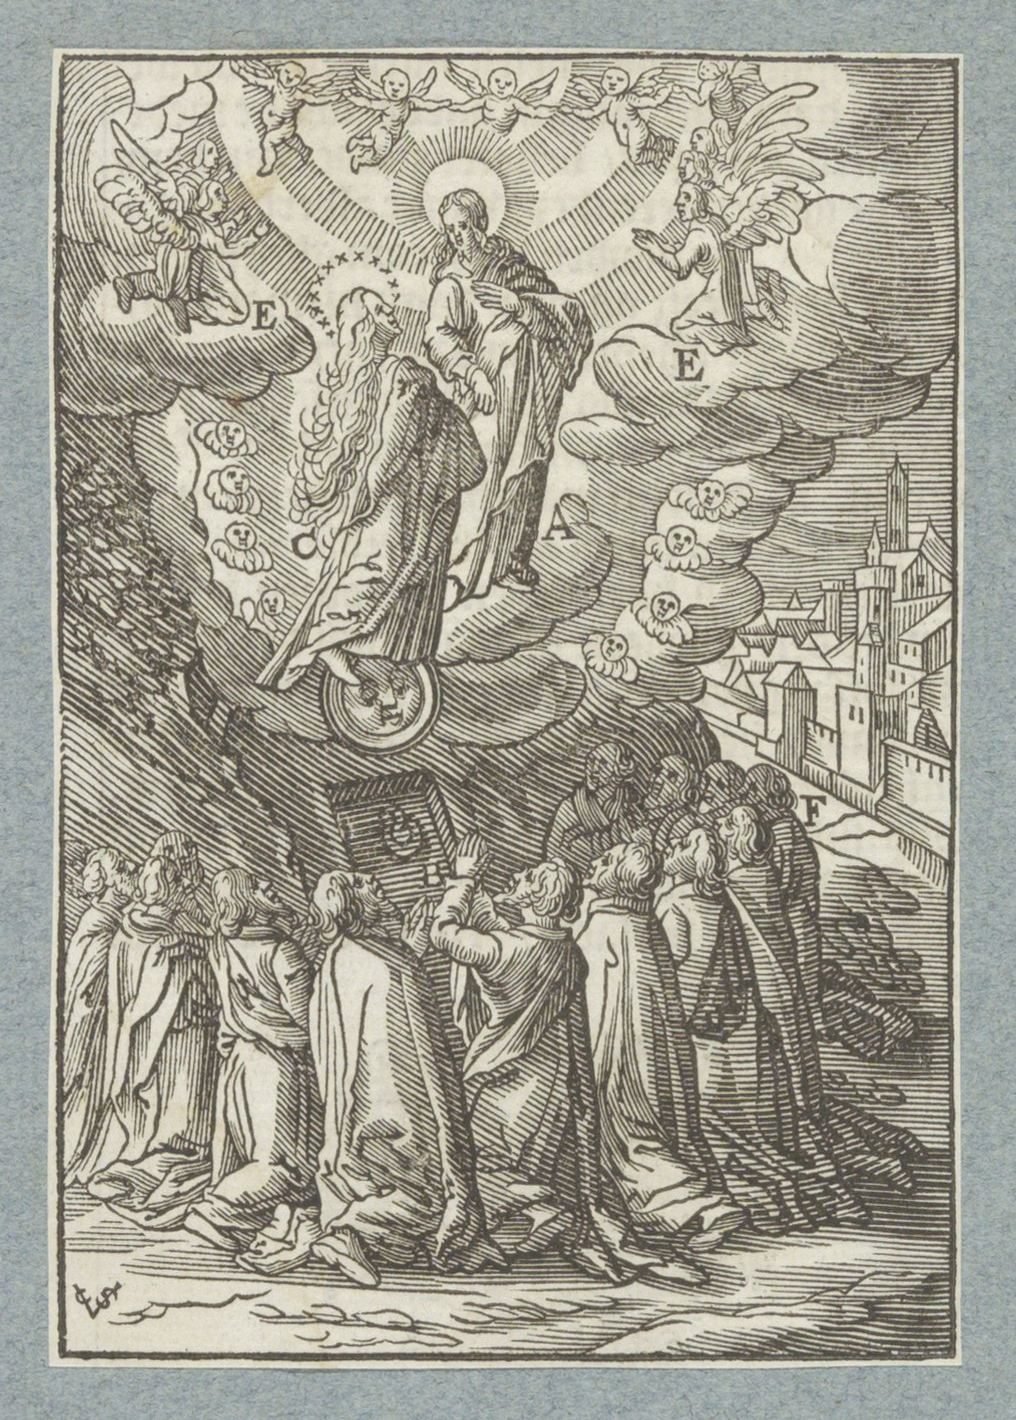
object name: book illustration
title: Hemelvaart van Maria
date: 1629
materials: paper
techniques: letterpress printing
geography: amsterdam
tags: the assumption of mary ('assumptio corporis'): she is borne into heaven by angels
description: De prent is afkomstig uit een van de uitgaven van P.J. Paets uit Amsterdam. De prent wordt voor het eerst gebruikt in: Der Zielen Lust-hof. Leuven, I.Jacbosz voor P.J. Paets [= Amsterdam, P.J. Paets], 1629. De voorstelling is gekopieerd naar een prent van Hieronymus Wierix voor: Nadal, Jerónimo. Evangelicae Historiae Imagines. Antwerpen, M. Nutius, 1593.